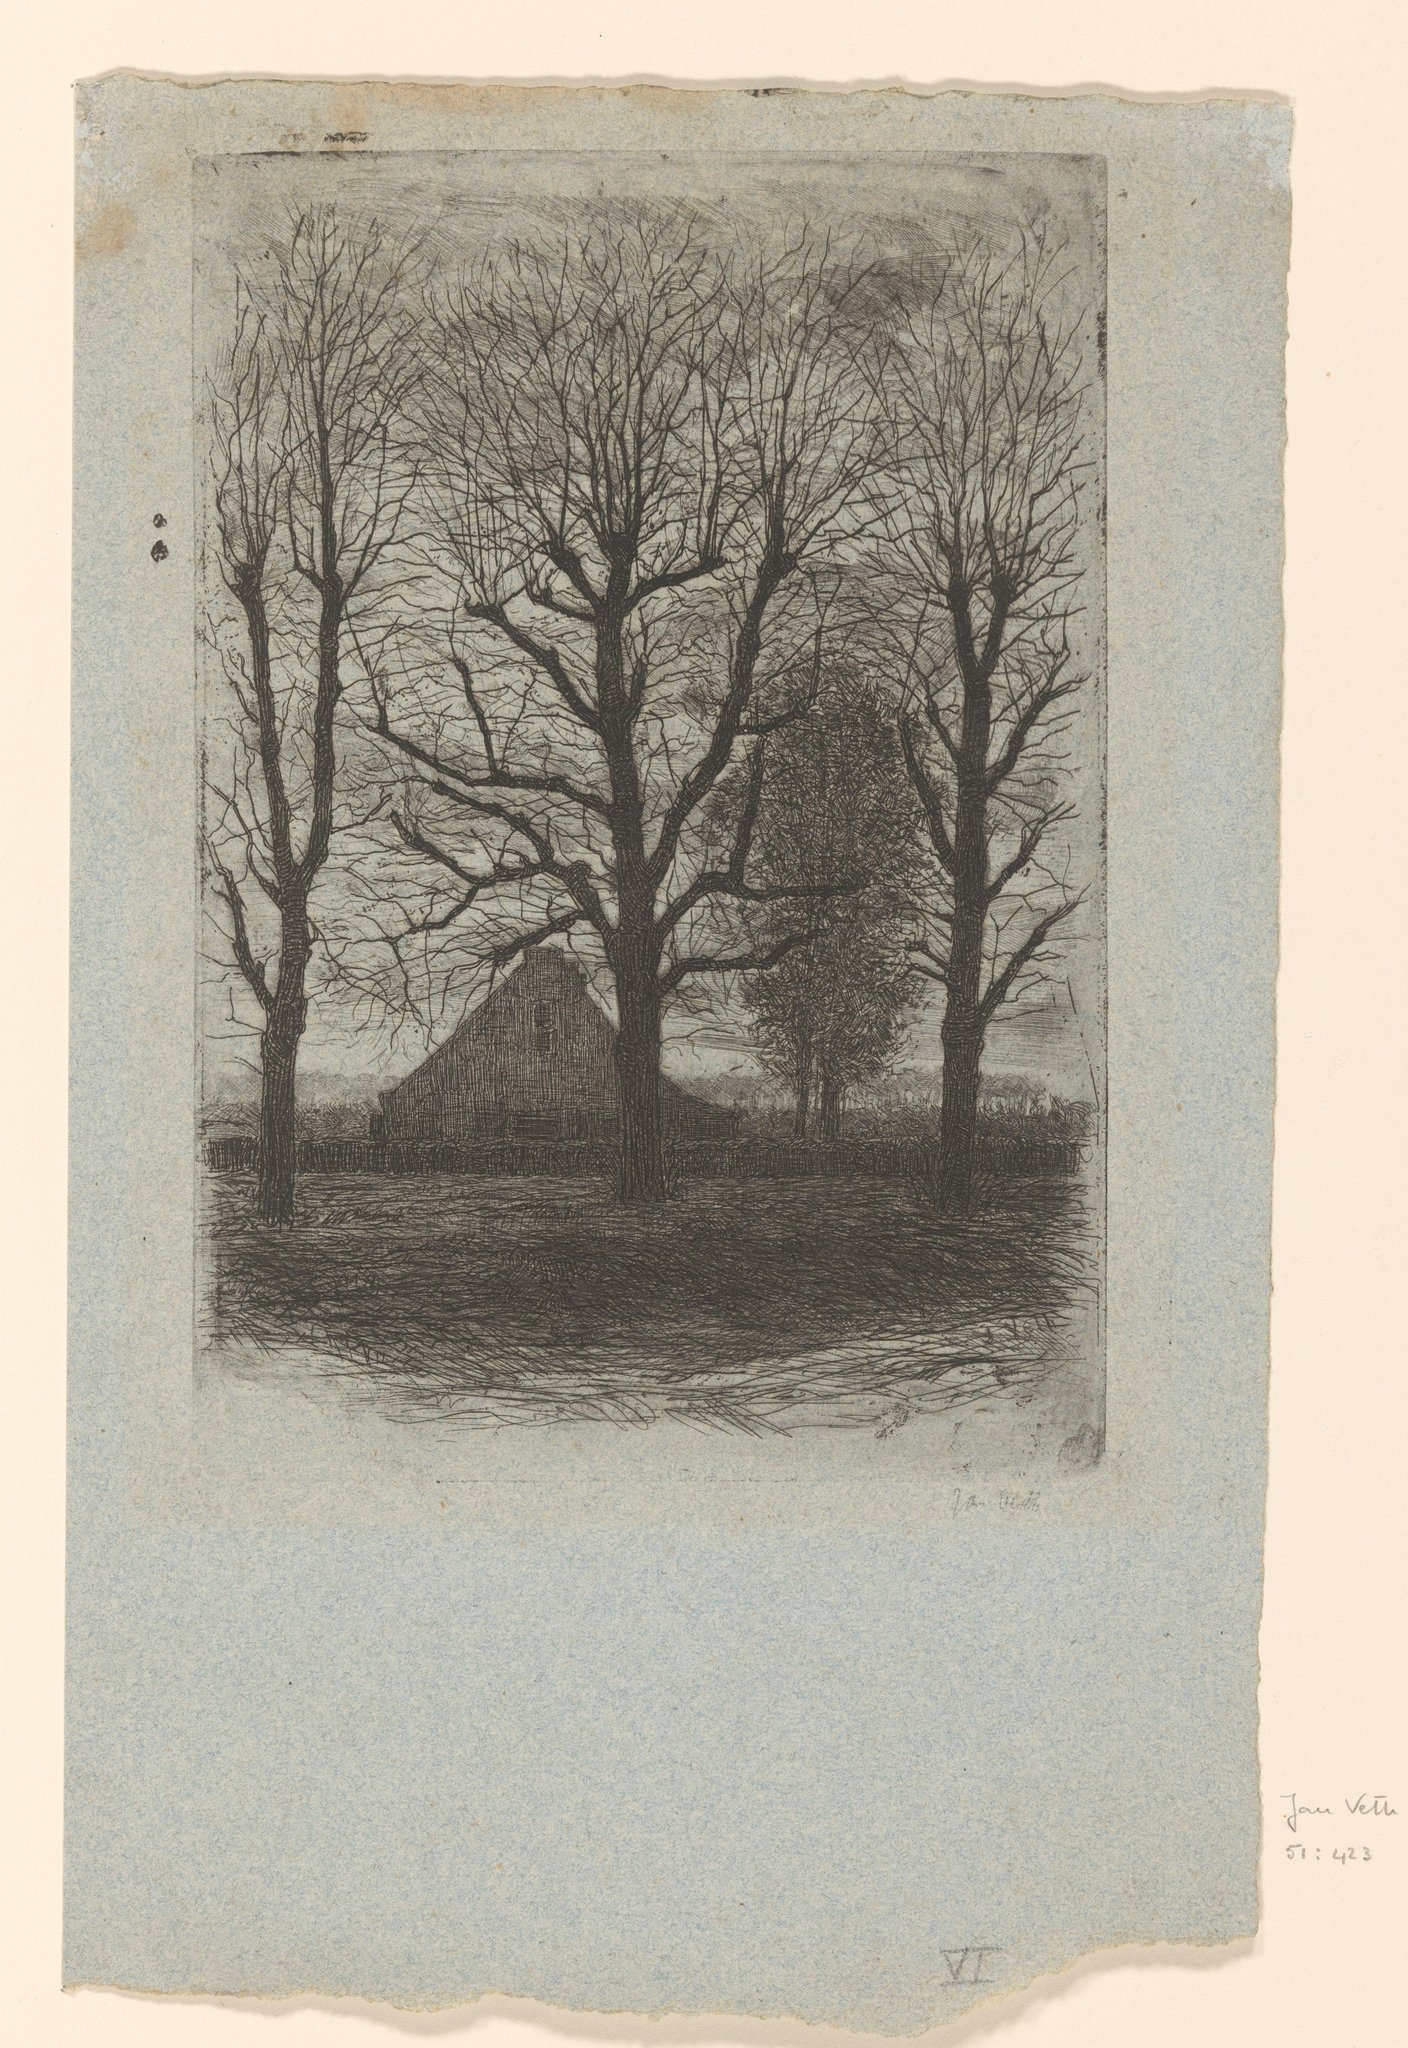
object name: print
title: Boerderij tussen hoge bomen, Ewijkshoeve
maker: jan veth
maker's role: designer, draughtsman, painter, print maker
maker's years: 1864-1925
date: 1886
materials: paper, pencil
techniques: etching, intaglio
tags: farm or solitary house in landscape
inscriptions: collector's mark: Lugt 2228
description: Enkele getekende lijnen op verso, mogelijk een schets voor een boom.